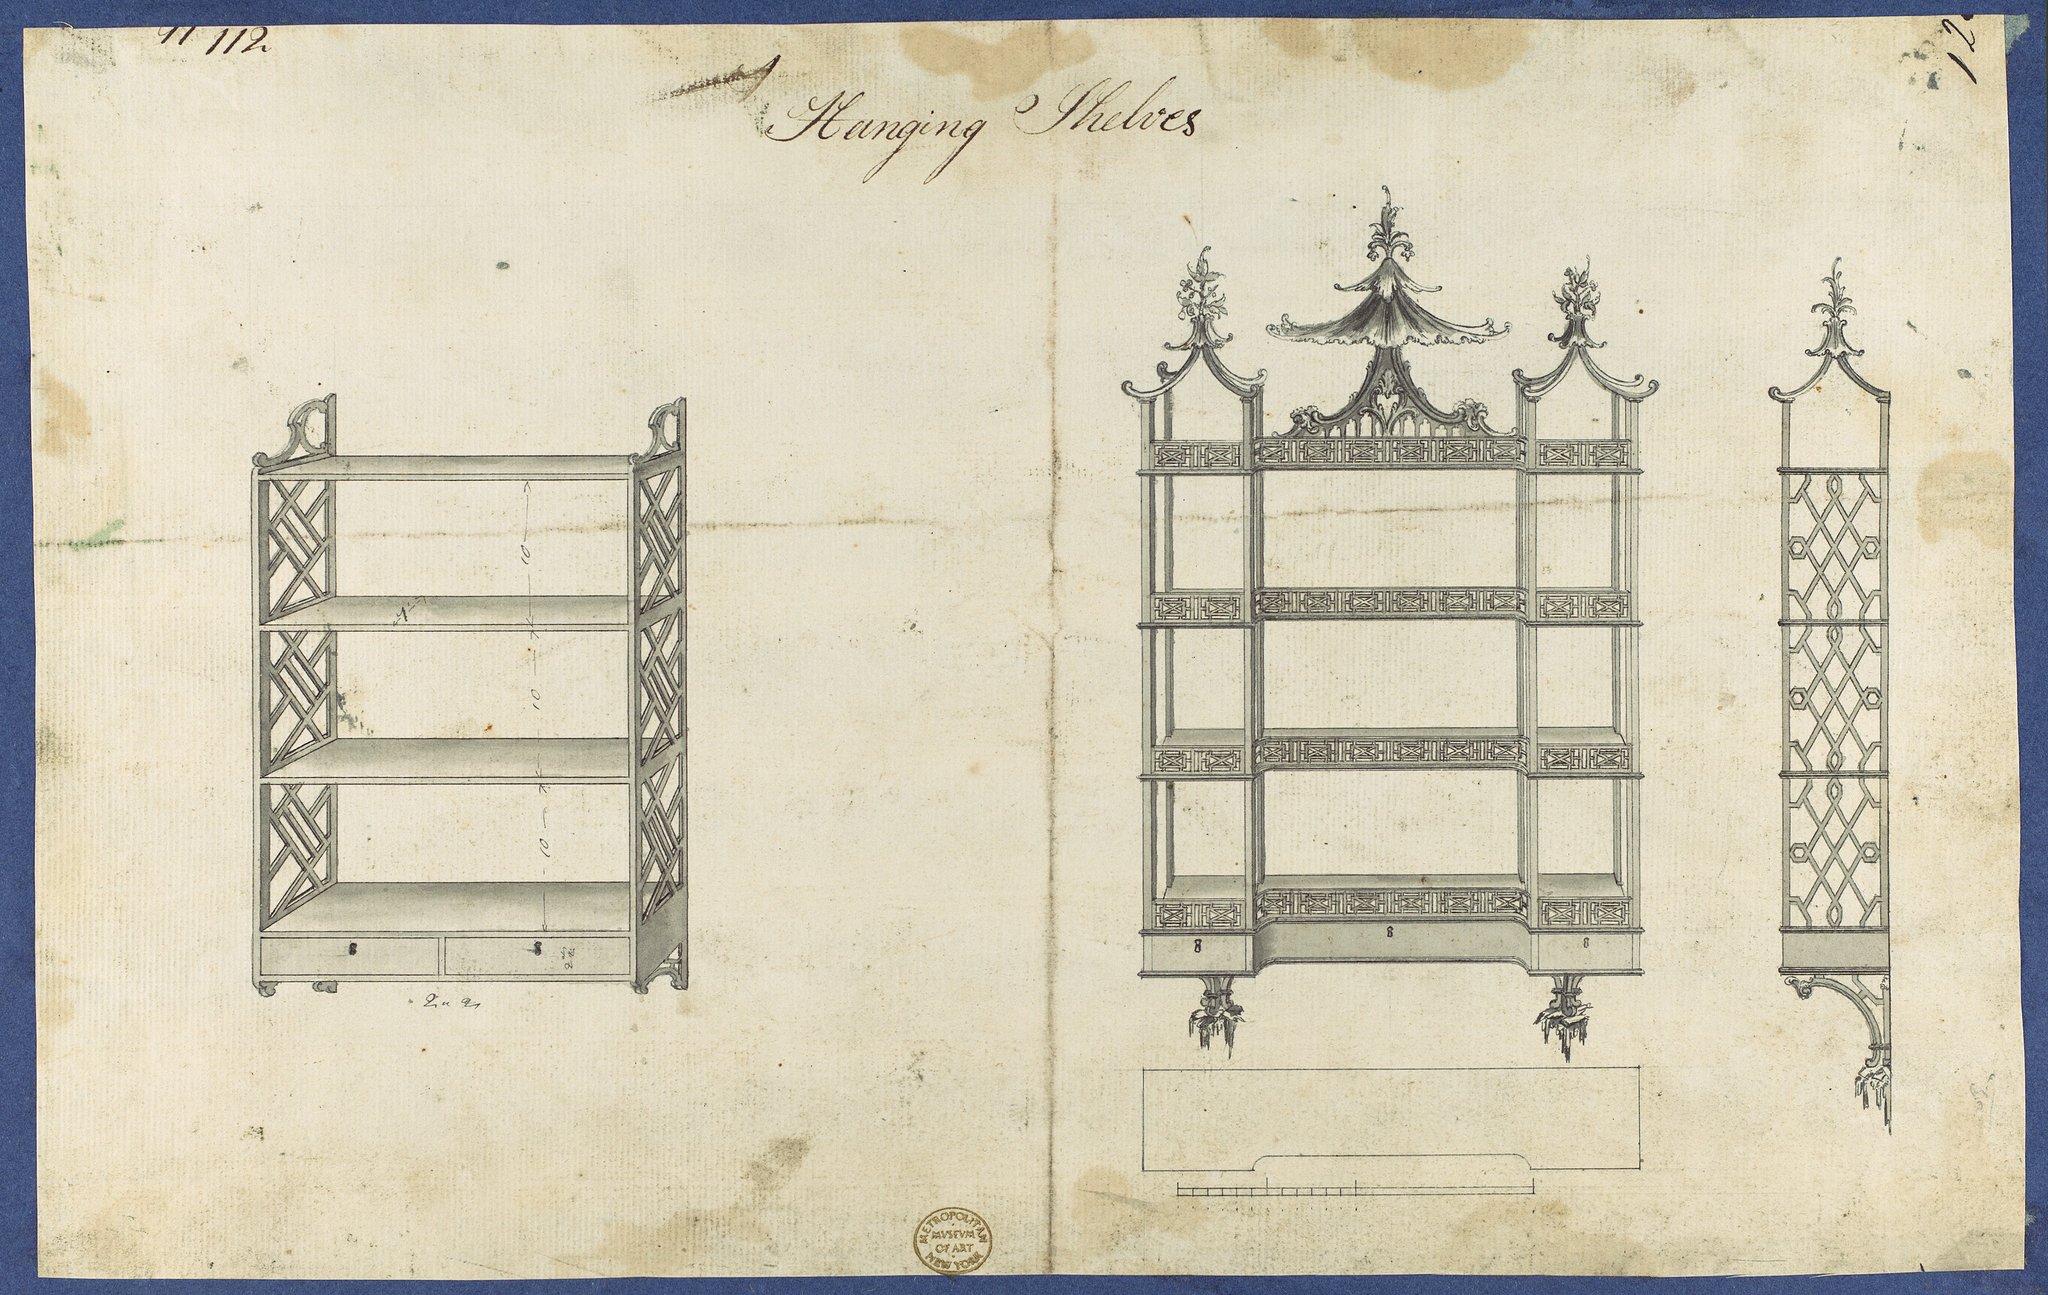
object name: drawing ornament architecture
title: Hanging Shelves, from Chippendale Drawings, Vol. II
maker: thomas chippendale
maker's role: artist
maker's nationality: british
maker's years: 1718-1779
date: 1753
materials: ink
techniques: wash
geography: london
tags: furniture